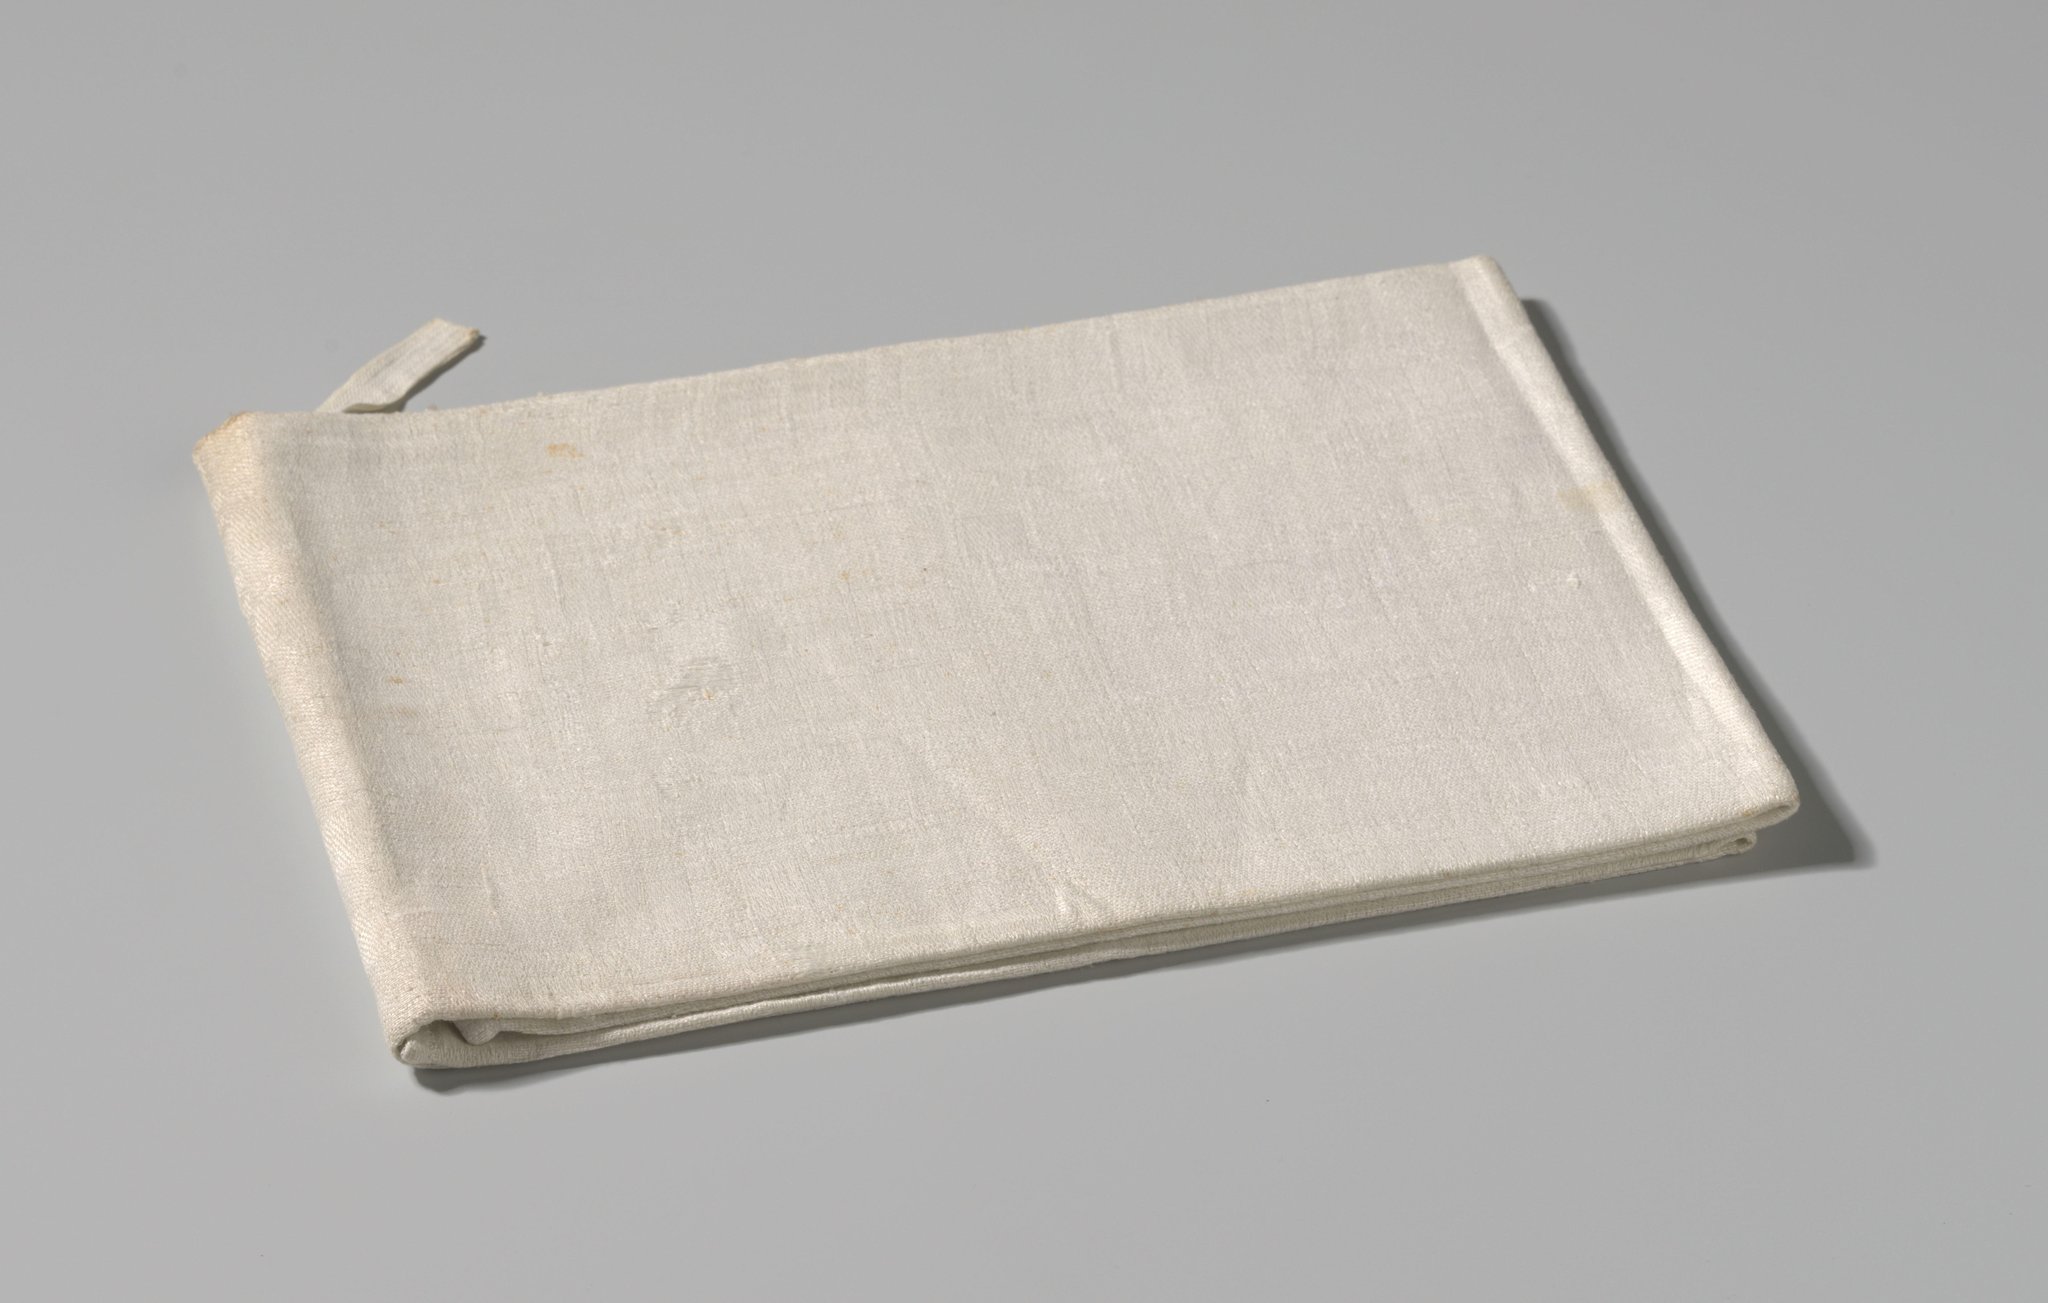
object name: napkin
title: Servet van linnen met pellenpatroon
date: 1750-1850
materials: linen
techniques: peeled fabric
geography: northern netherlands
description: wit linnen servet met een pellen patroon, merk HW 58